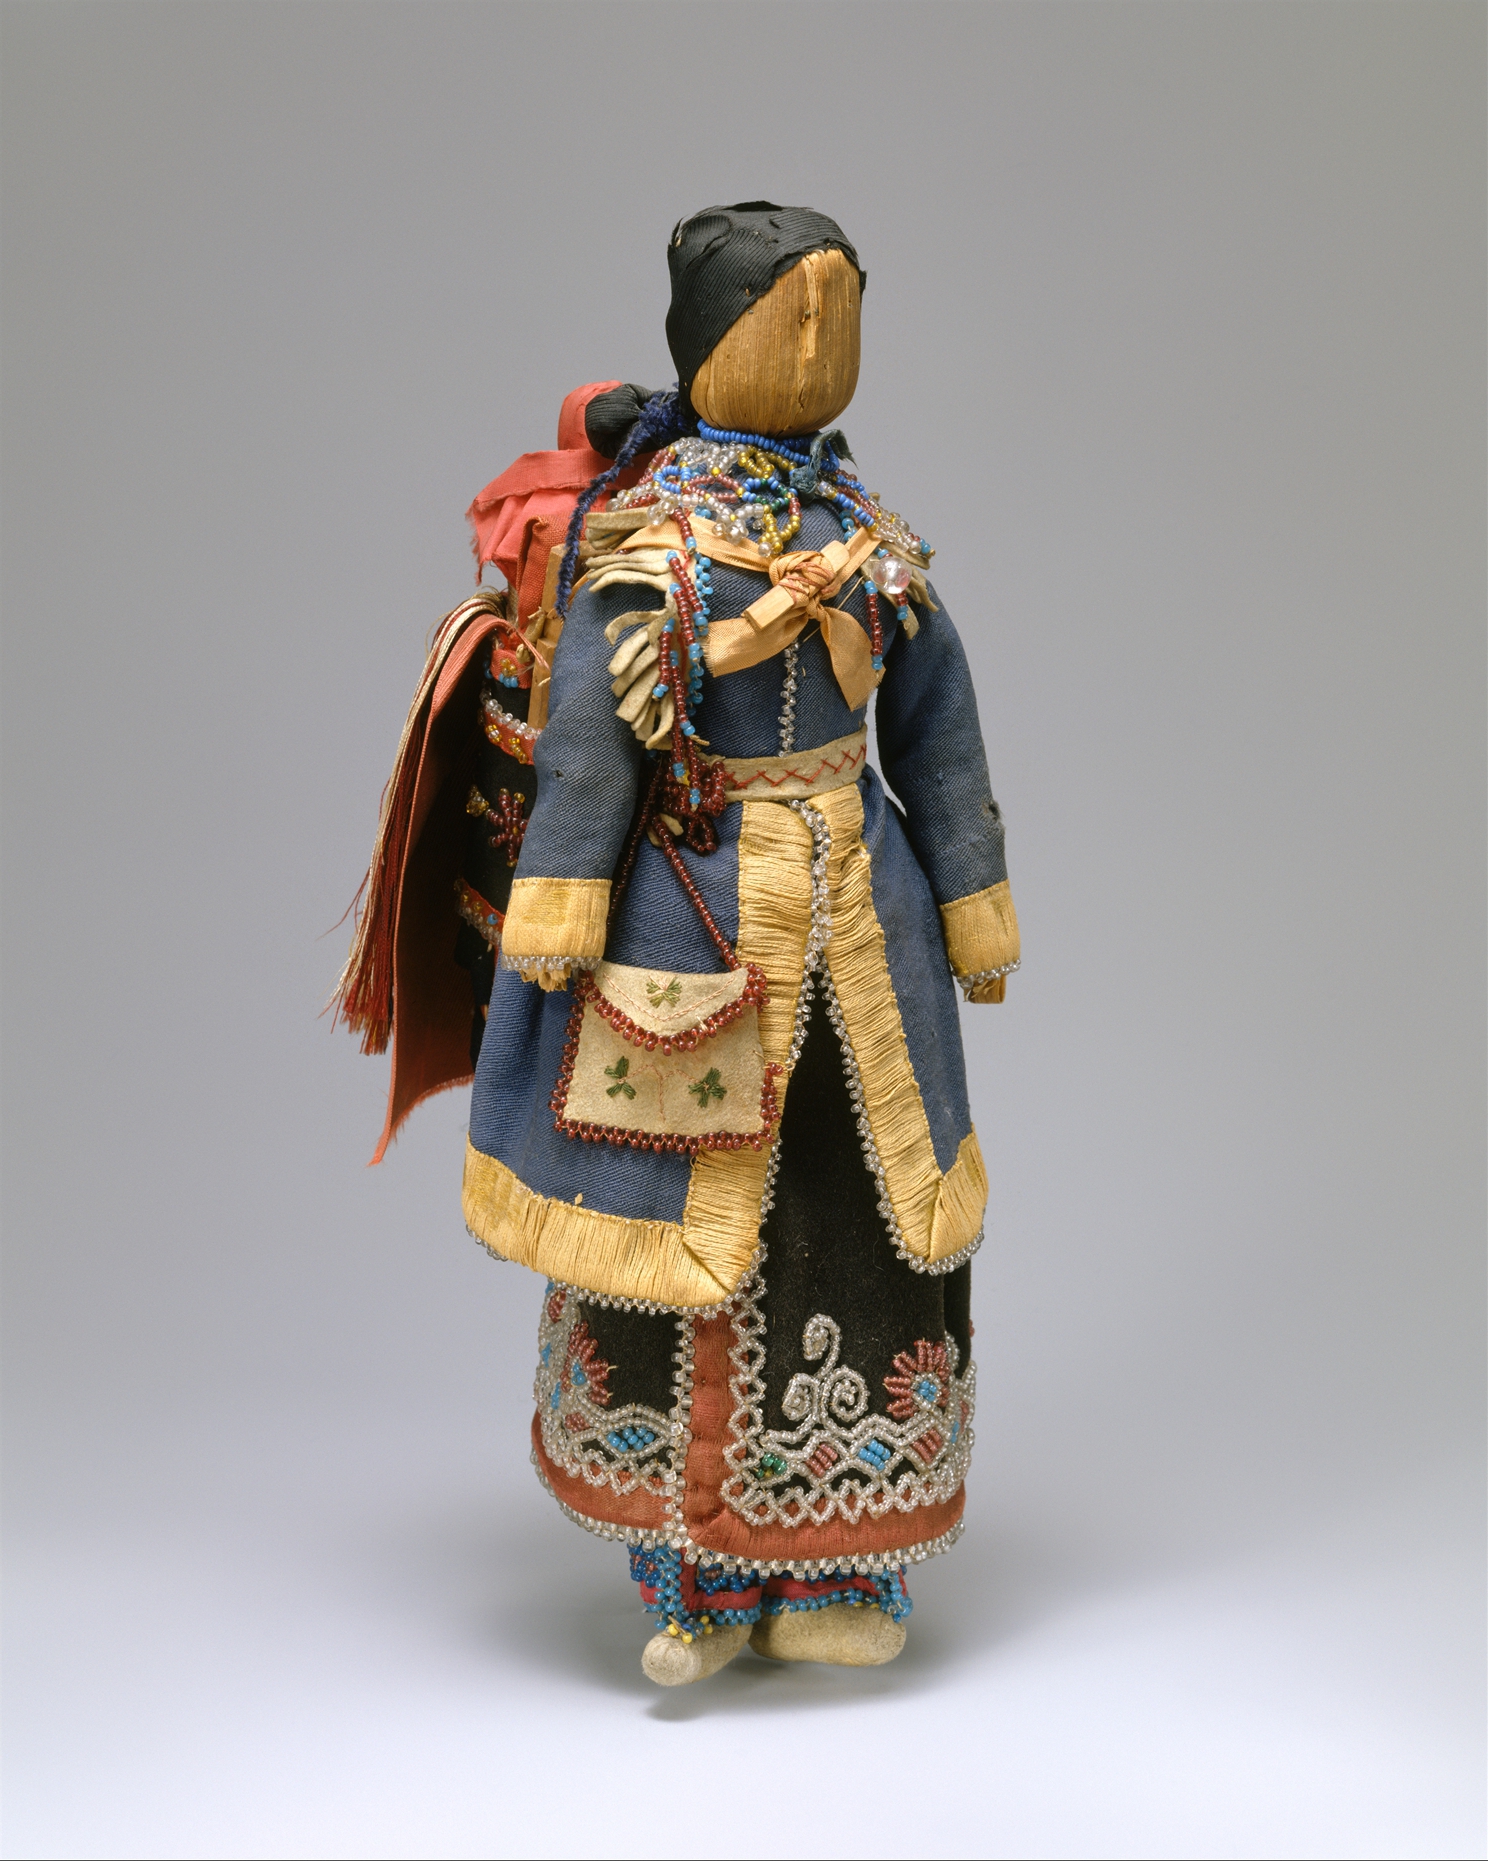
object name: doll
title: Mother-and-Child Doll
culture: seneca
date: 1870-1880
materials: cotton, glass, silk, skin, wool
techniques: tanning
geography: united states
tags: infants,mothers,dolls